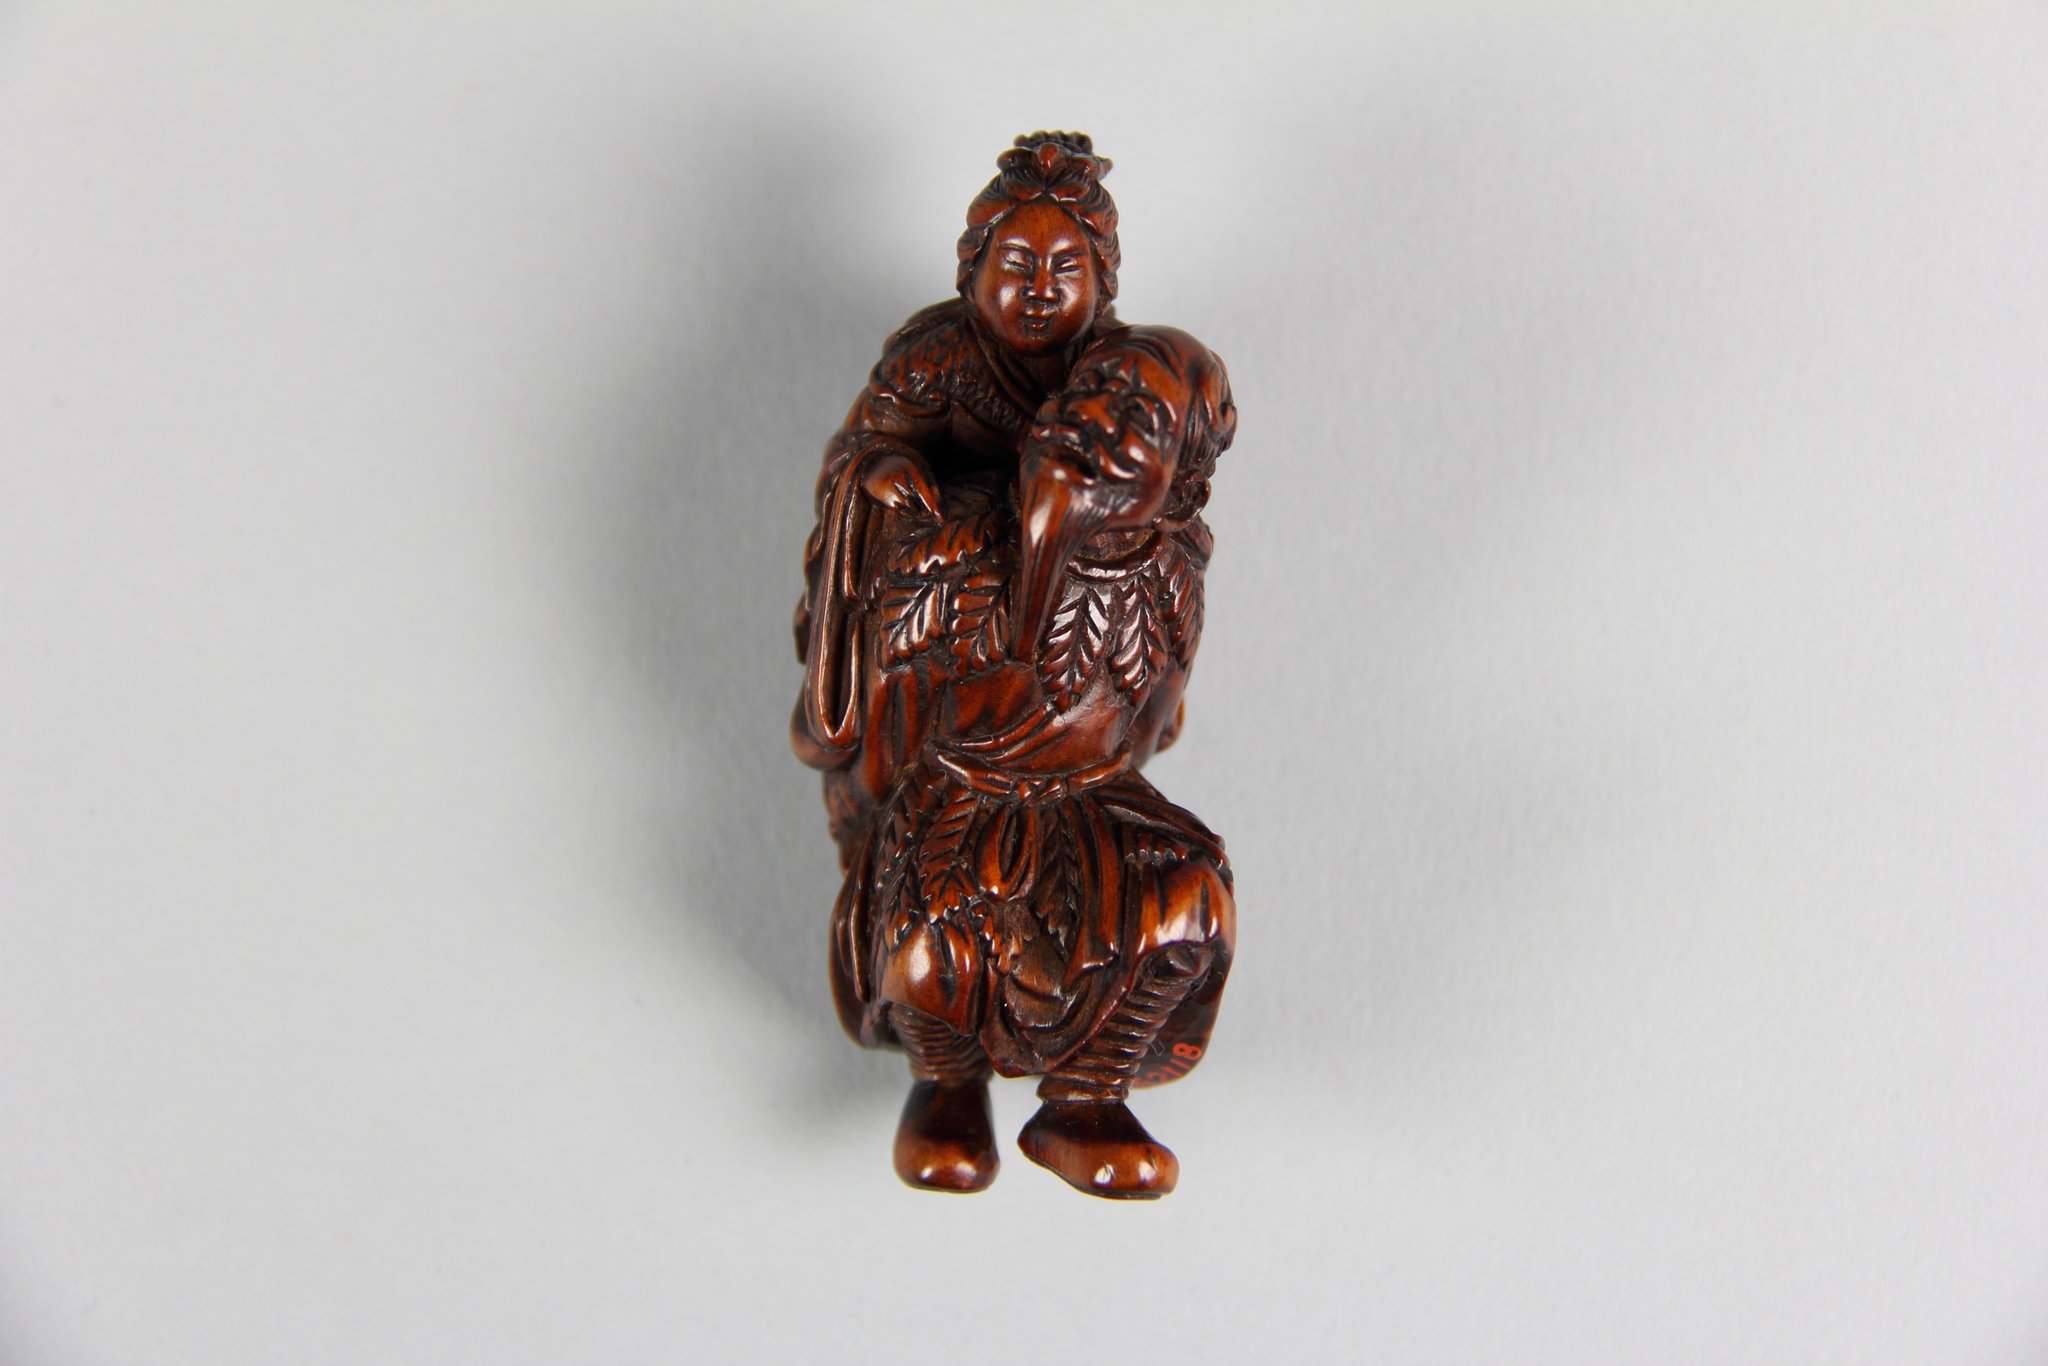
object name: netsuke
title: Netsuke of Old Man Carrying a Woman on His Back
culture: japanese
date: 1801-1900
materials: wood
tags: men,women